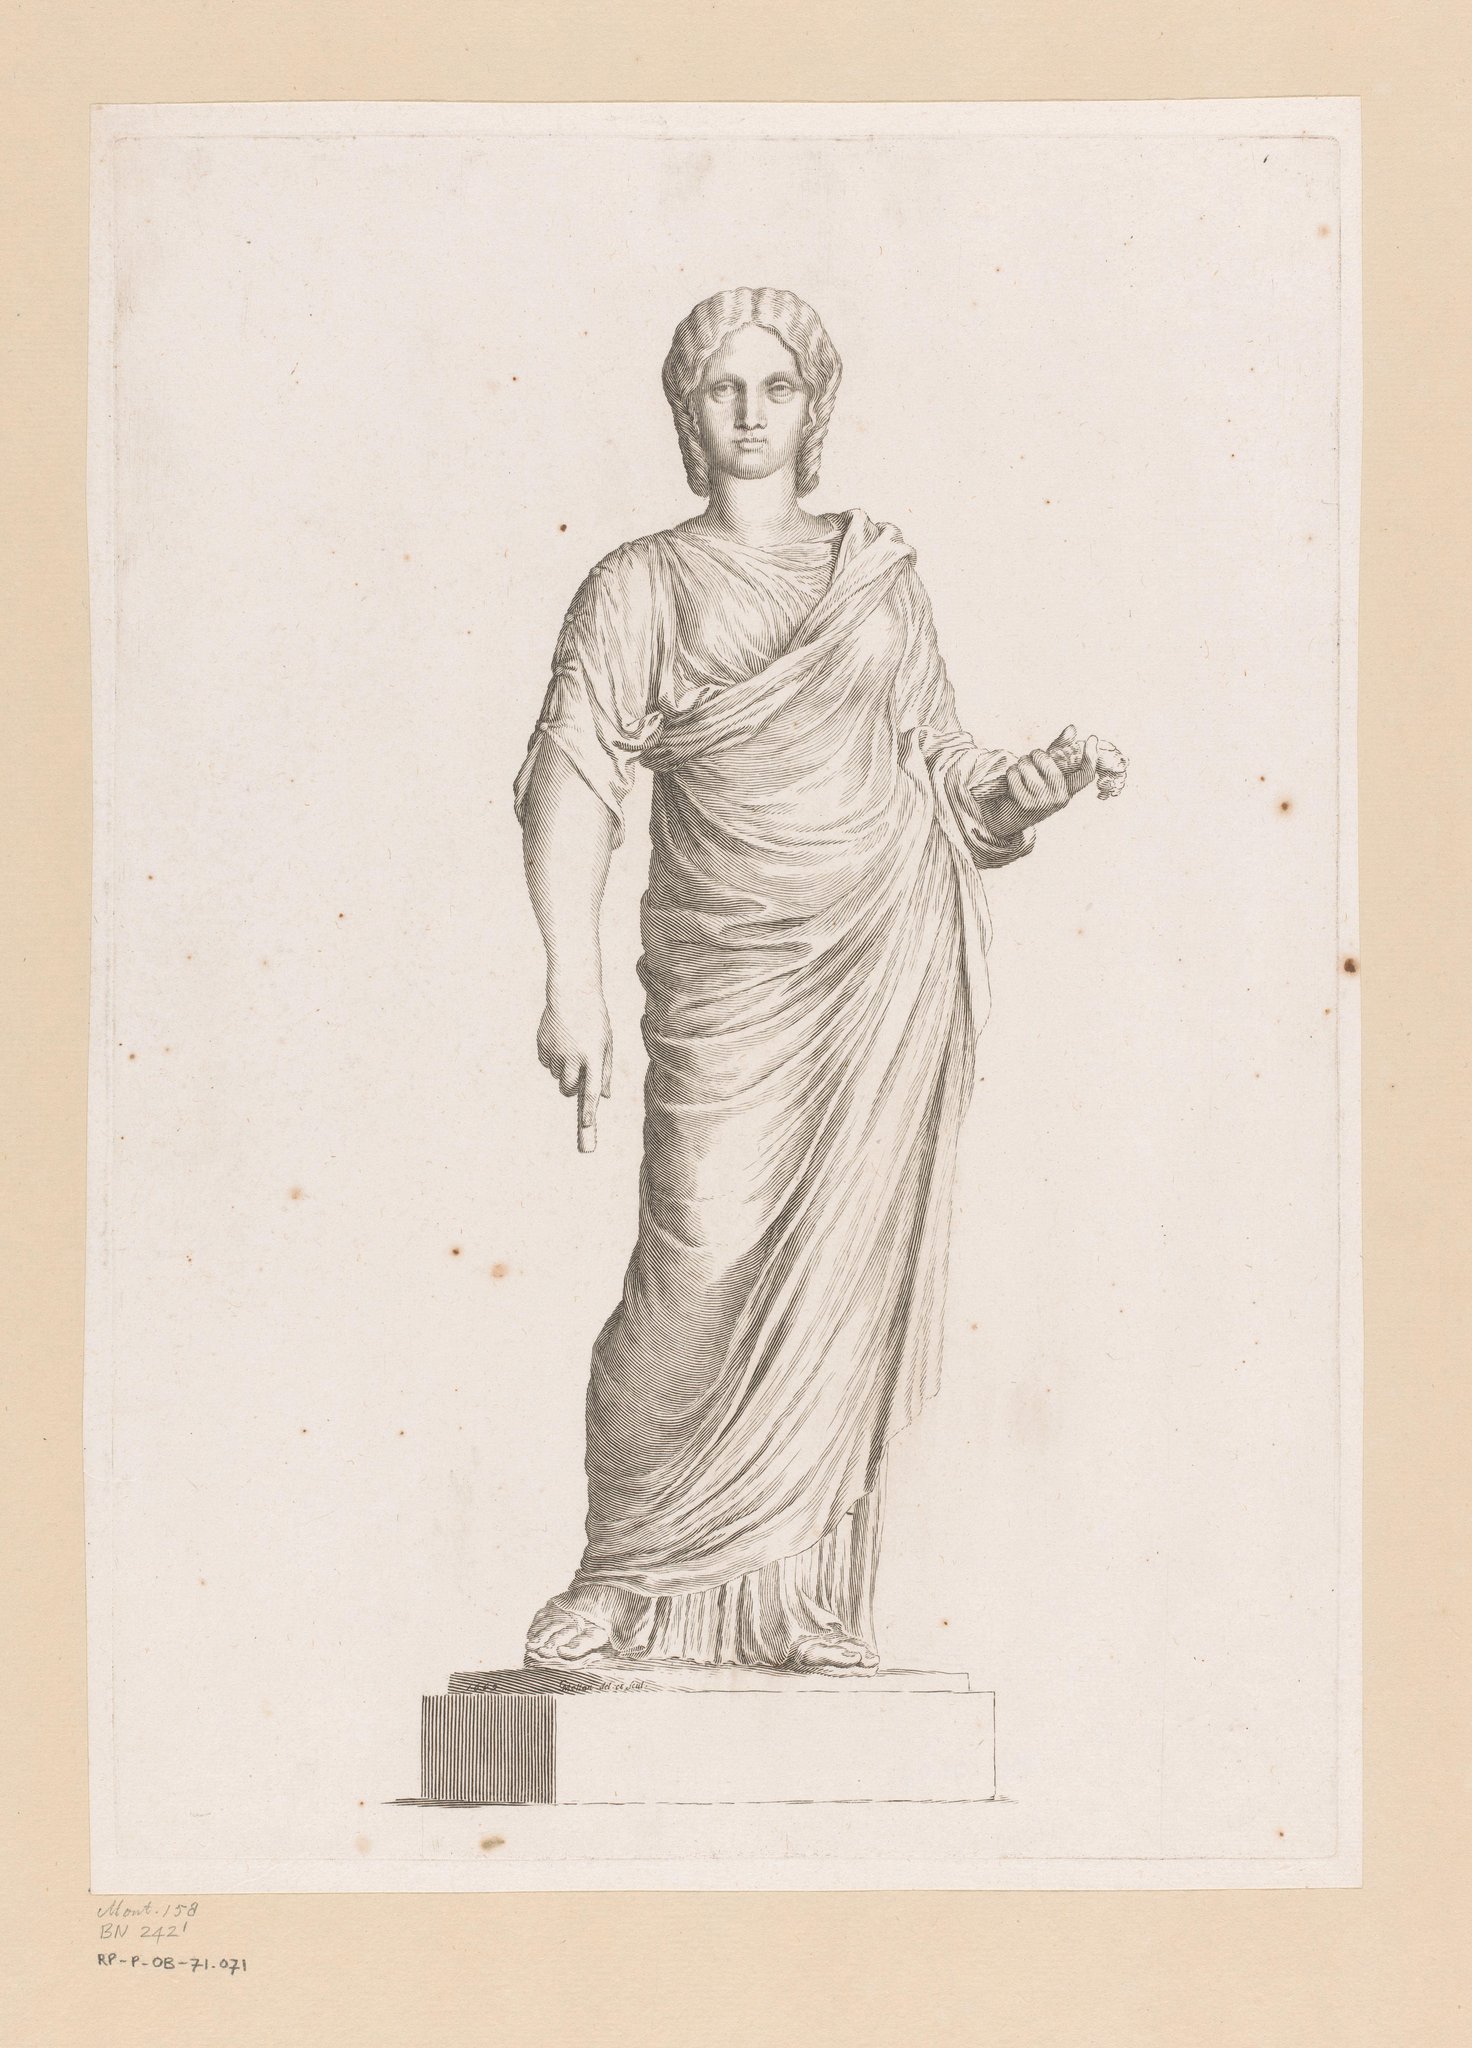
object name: book illustration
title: Standbeeld van vrouw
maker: claude mellan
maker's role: draughtsman, print maker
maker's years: 1598-1688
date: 1669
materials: paper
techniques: engraving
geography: paris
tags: piece of sculpture, reproduction of a piece of sculpture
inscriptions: collector's mark: Lugt 240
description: Prent gebruikt voor: Félibien, André. Tableaux du Cabinet du roy. Statues et bustes antiques des maisons royales. Parijs: Imprimerie Royale, 1677. Het boek bevat 61 prenten van beelden en bustes uit Franse koninklijke collectie. Mellan vervaardigde in totaal achttien platen (zie ook British Museum, inv.nr. 1874,0808.1488). De verblijfplaats van het beeld is onbekend.